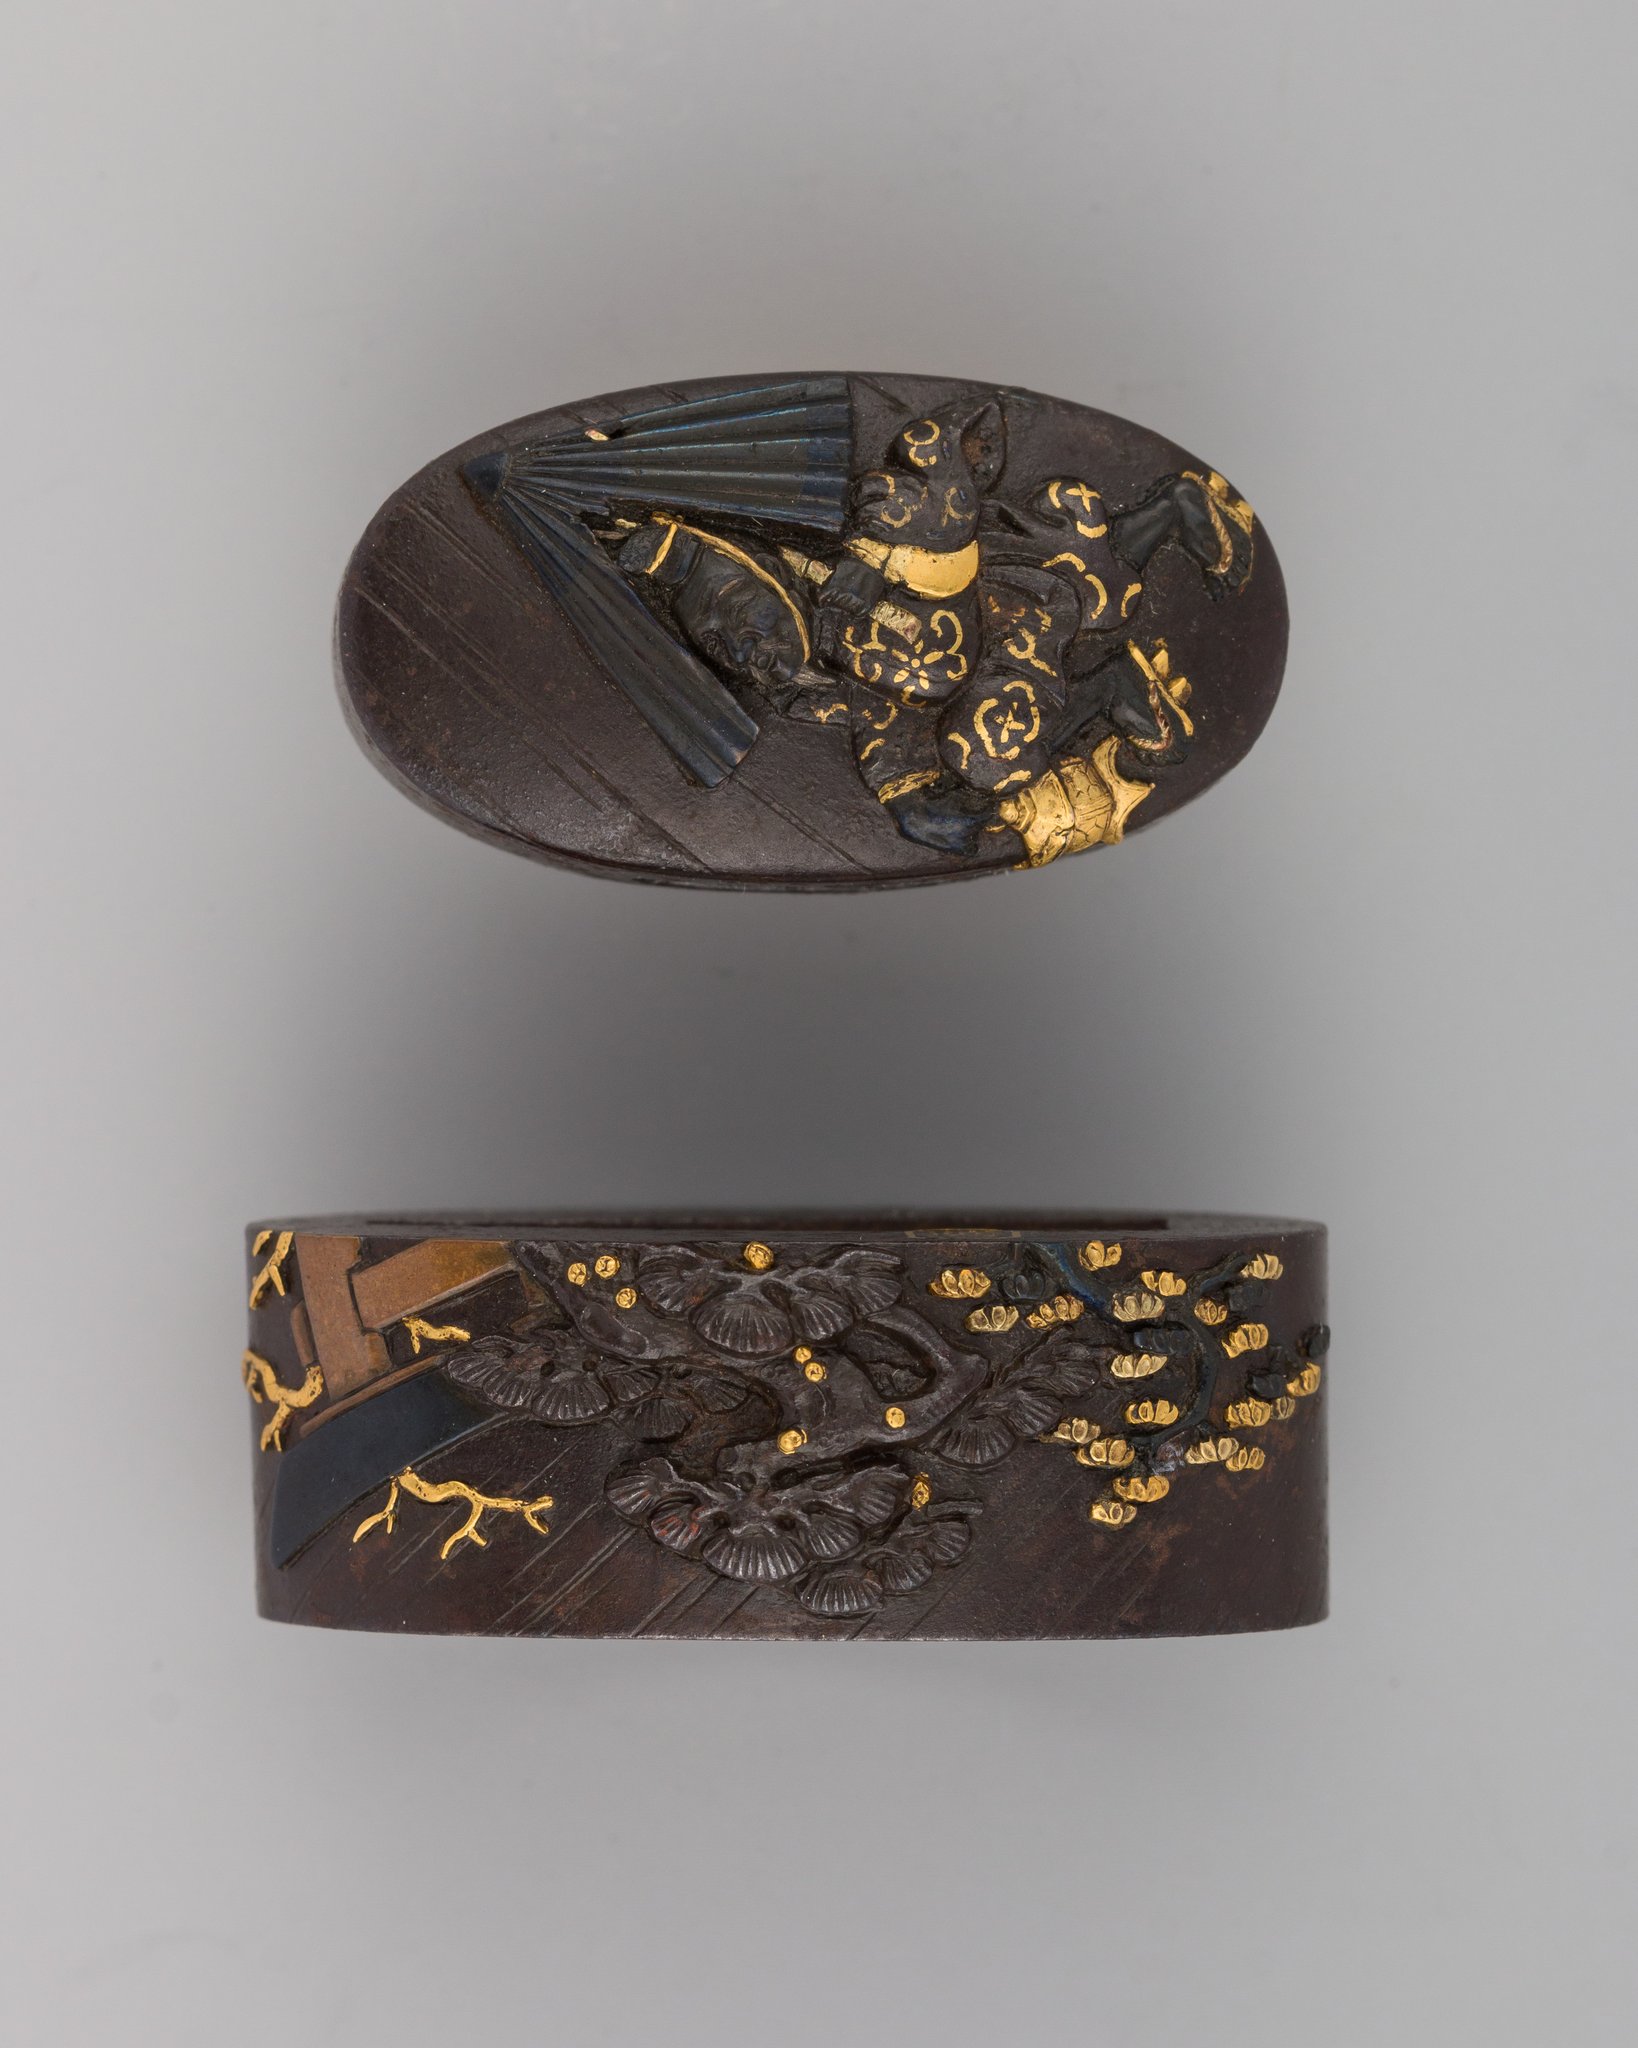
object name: sword hilt collar and pommel fuchigashira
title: Sword-Hilt Collar and Pommel (Fuchigashira)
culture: japanese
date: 1701-1800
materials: copper, gold alloy, gold, iron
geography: japan